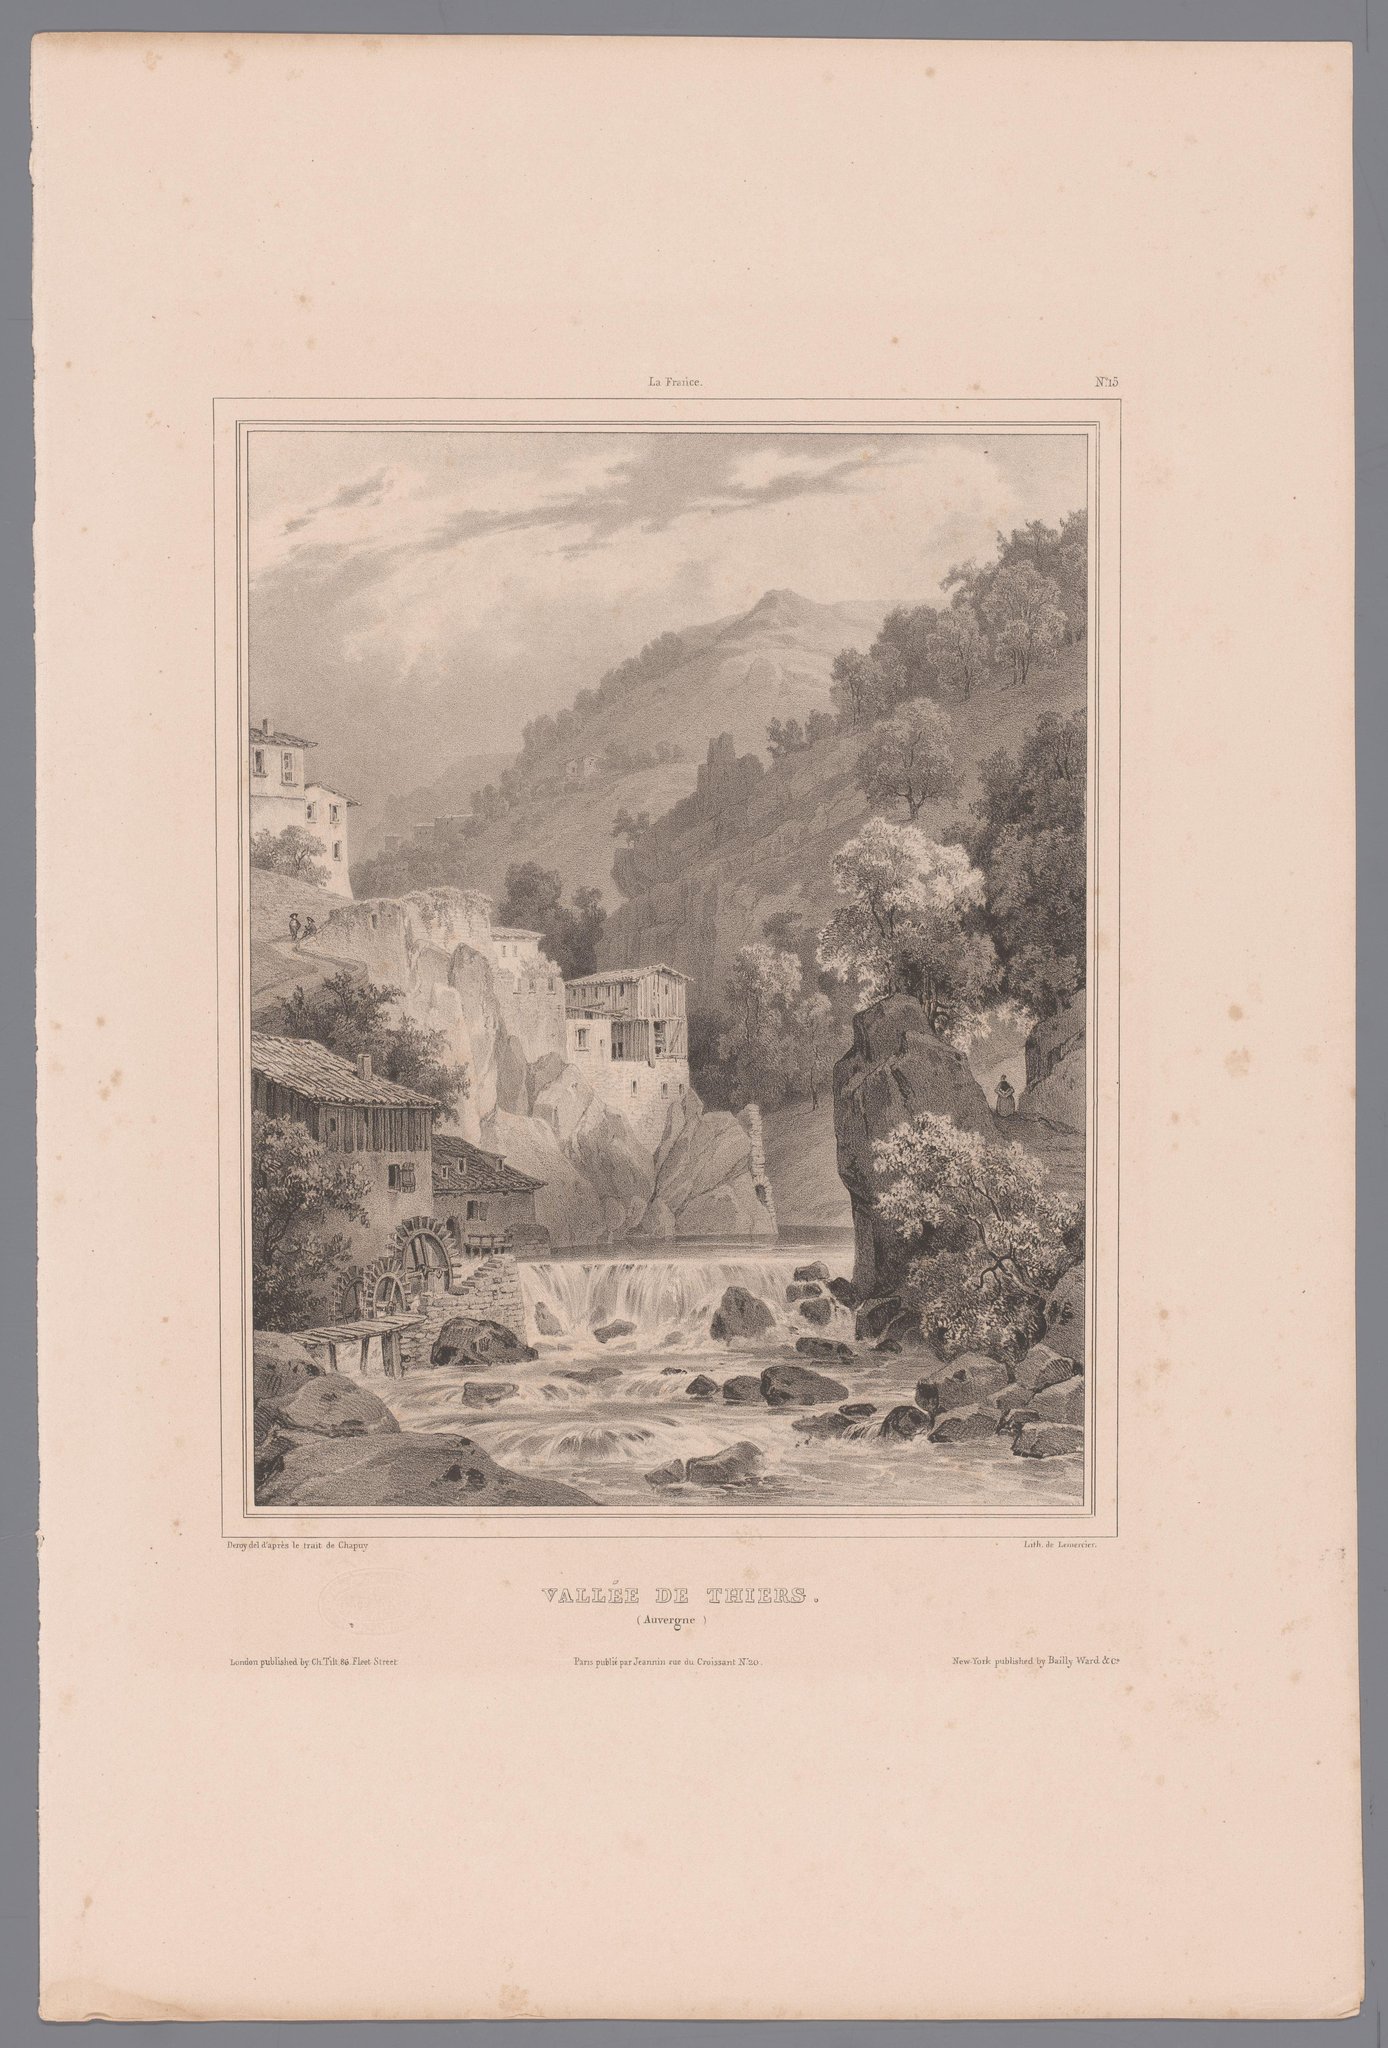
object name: print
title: La France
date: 1834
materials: paper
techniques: lithograph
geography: new york city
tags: village, mountains (+ landscape with figures, staffage), watermill, brook (+ landscape with figures, staffage)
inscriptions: check stamp: Lugt 1397c, collector's mark: Lugt 2228a